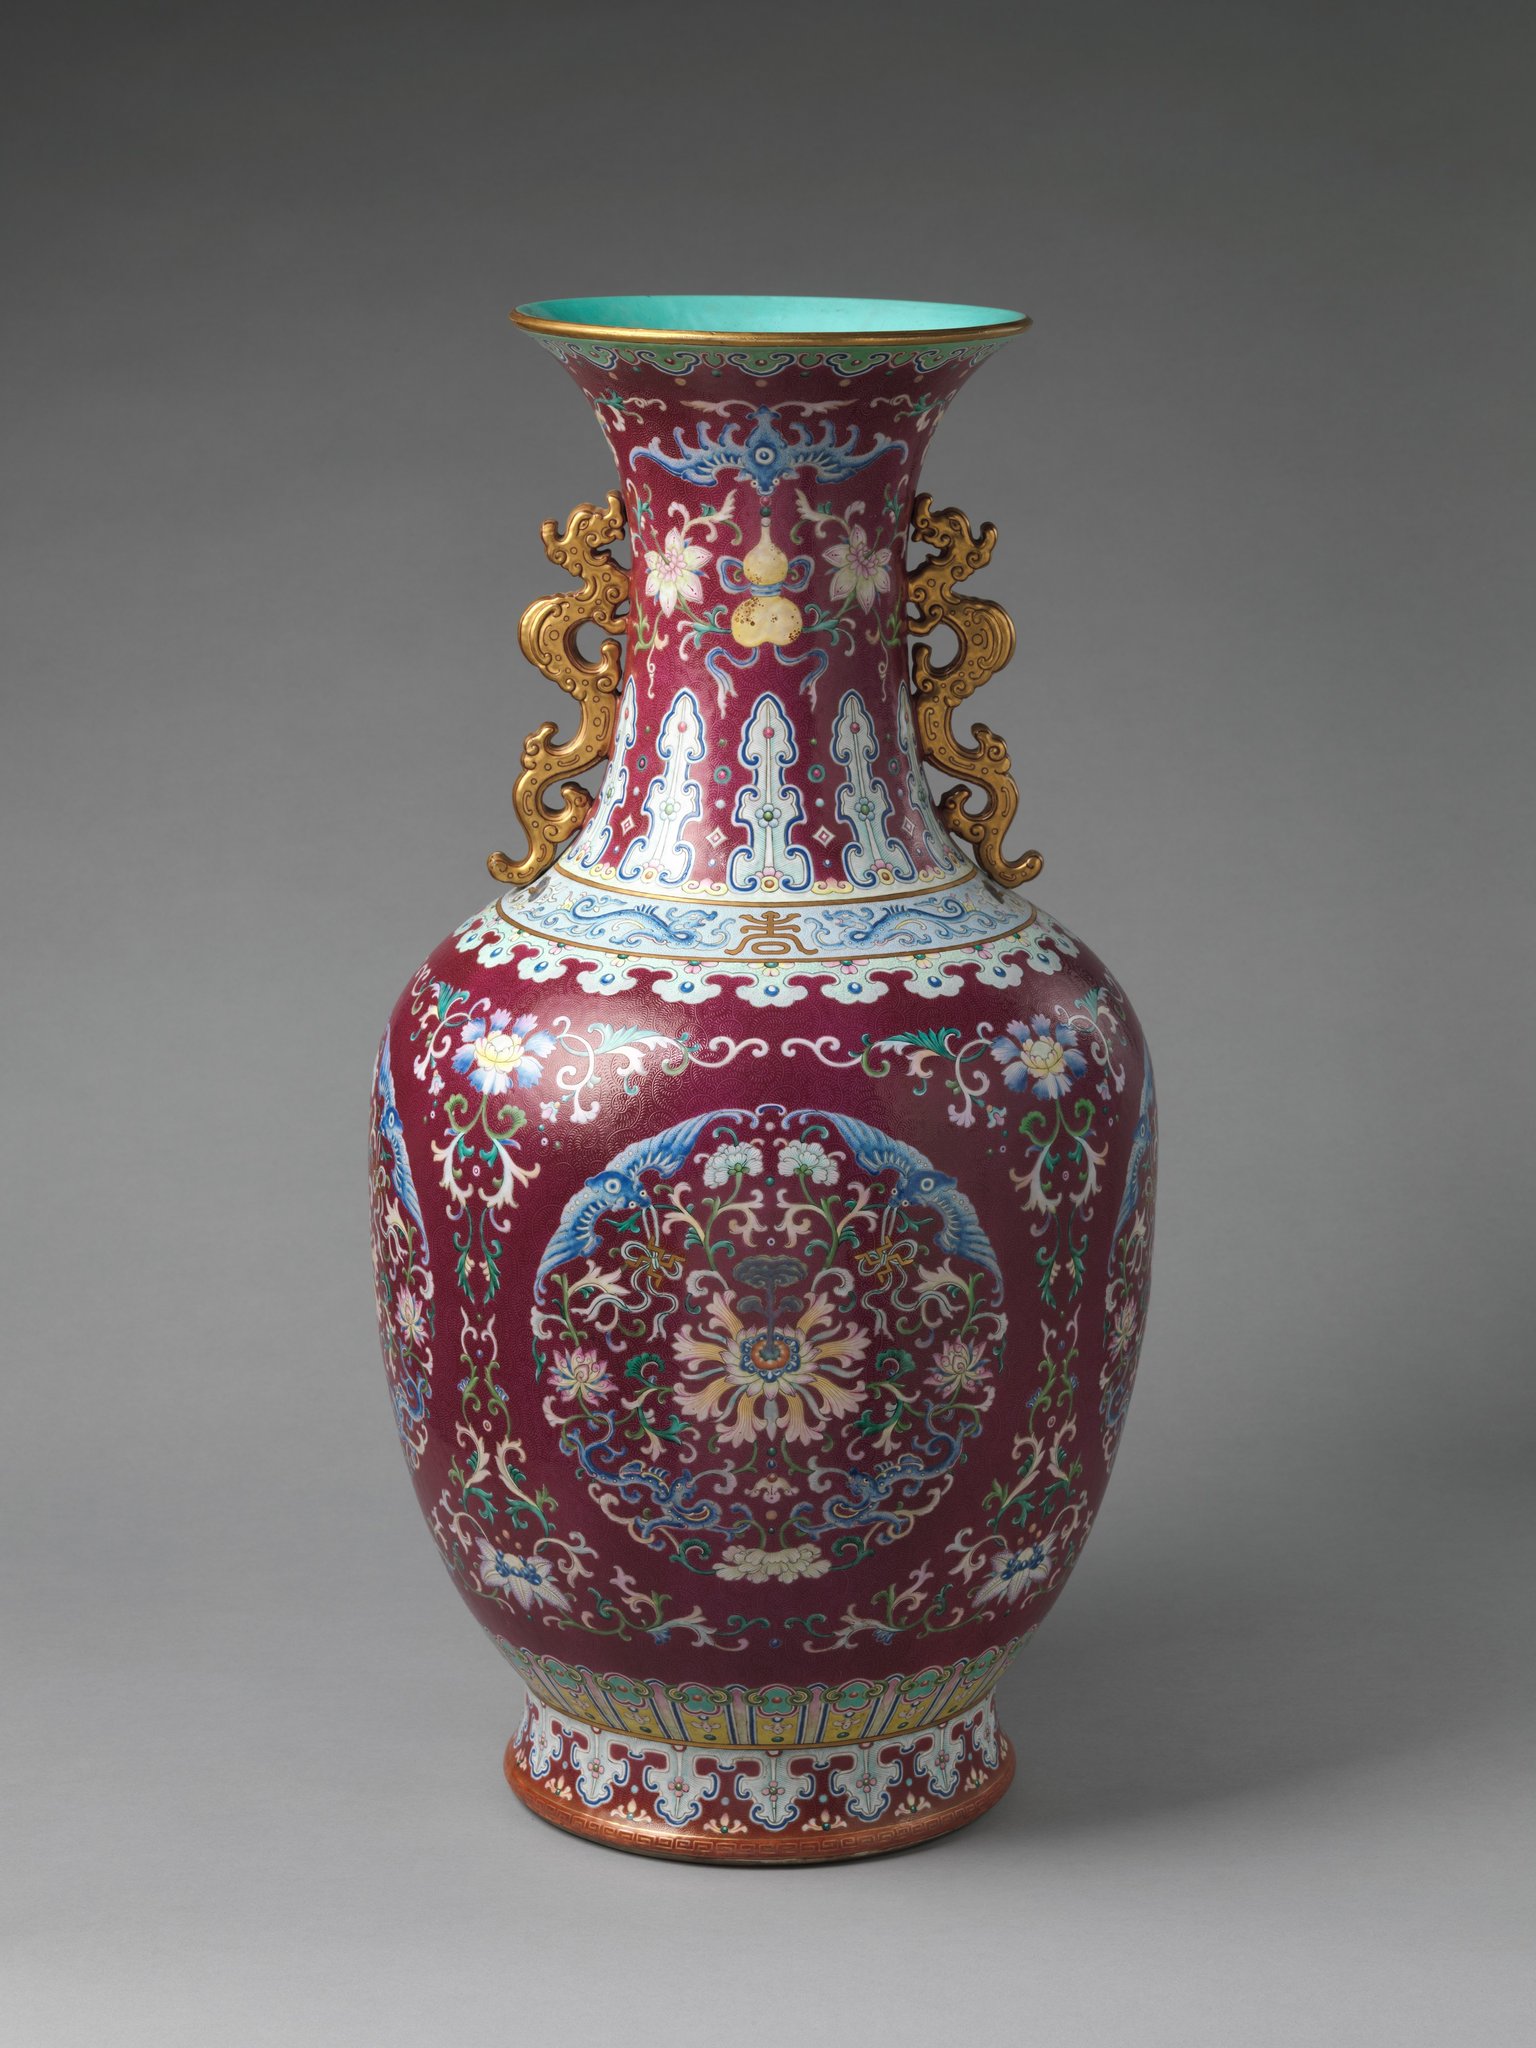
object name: vase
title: Vase decorated with floral medallions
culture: chinese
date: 1734-1766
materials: enamel, porcelain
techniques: engraving, gilding, overglaze, painting